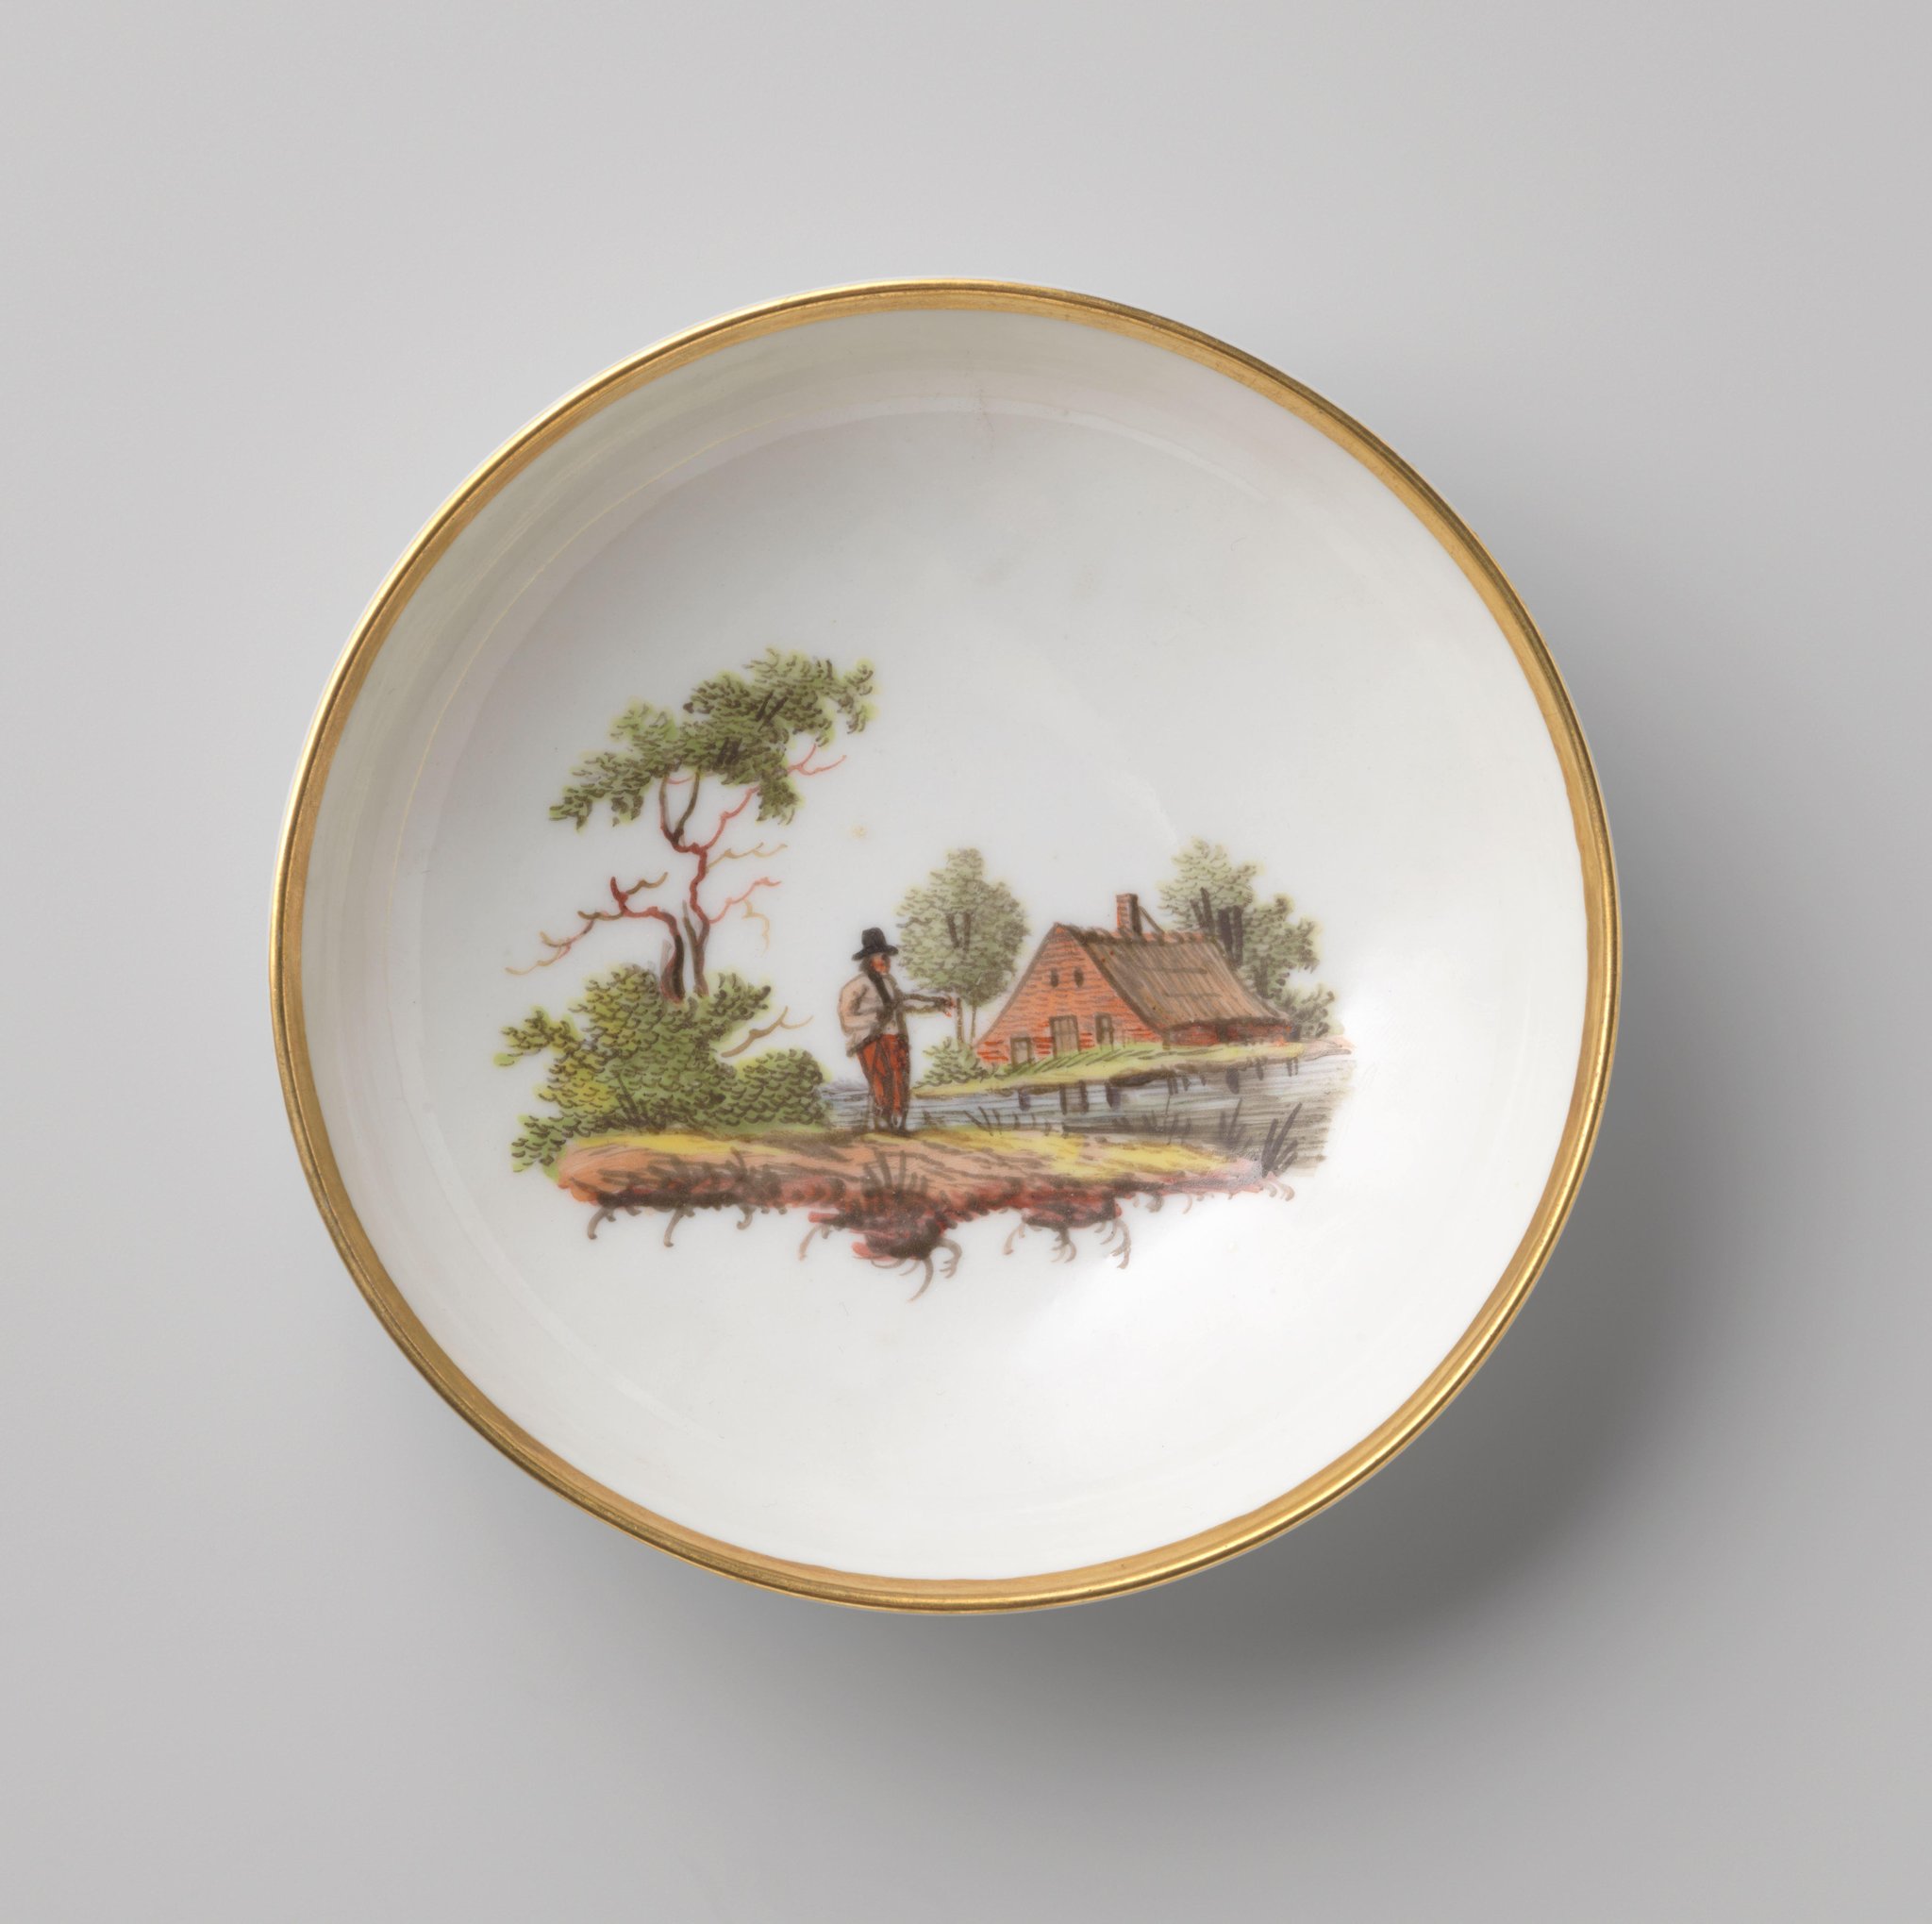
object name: kop en schotel, kop en schotel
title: Schotel met riviergezicht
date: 1809-1814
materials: porcelain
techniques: painted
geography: nieuwer-amstel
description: Schotel versierd met een veelkleurig landschap. Een wijzende man en een boerderij langs de rivier. Langs de rand een gouden rand. Gemerkt: Amstel.